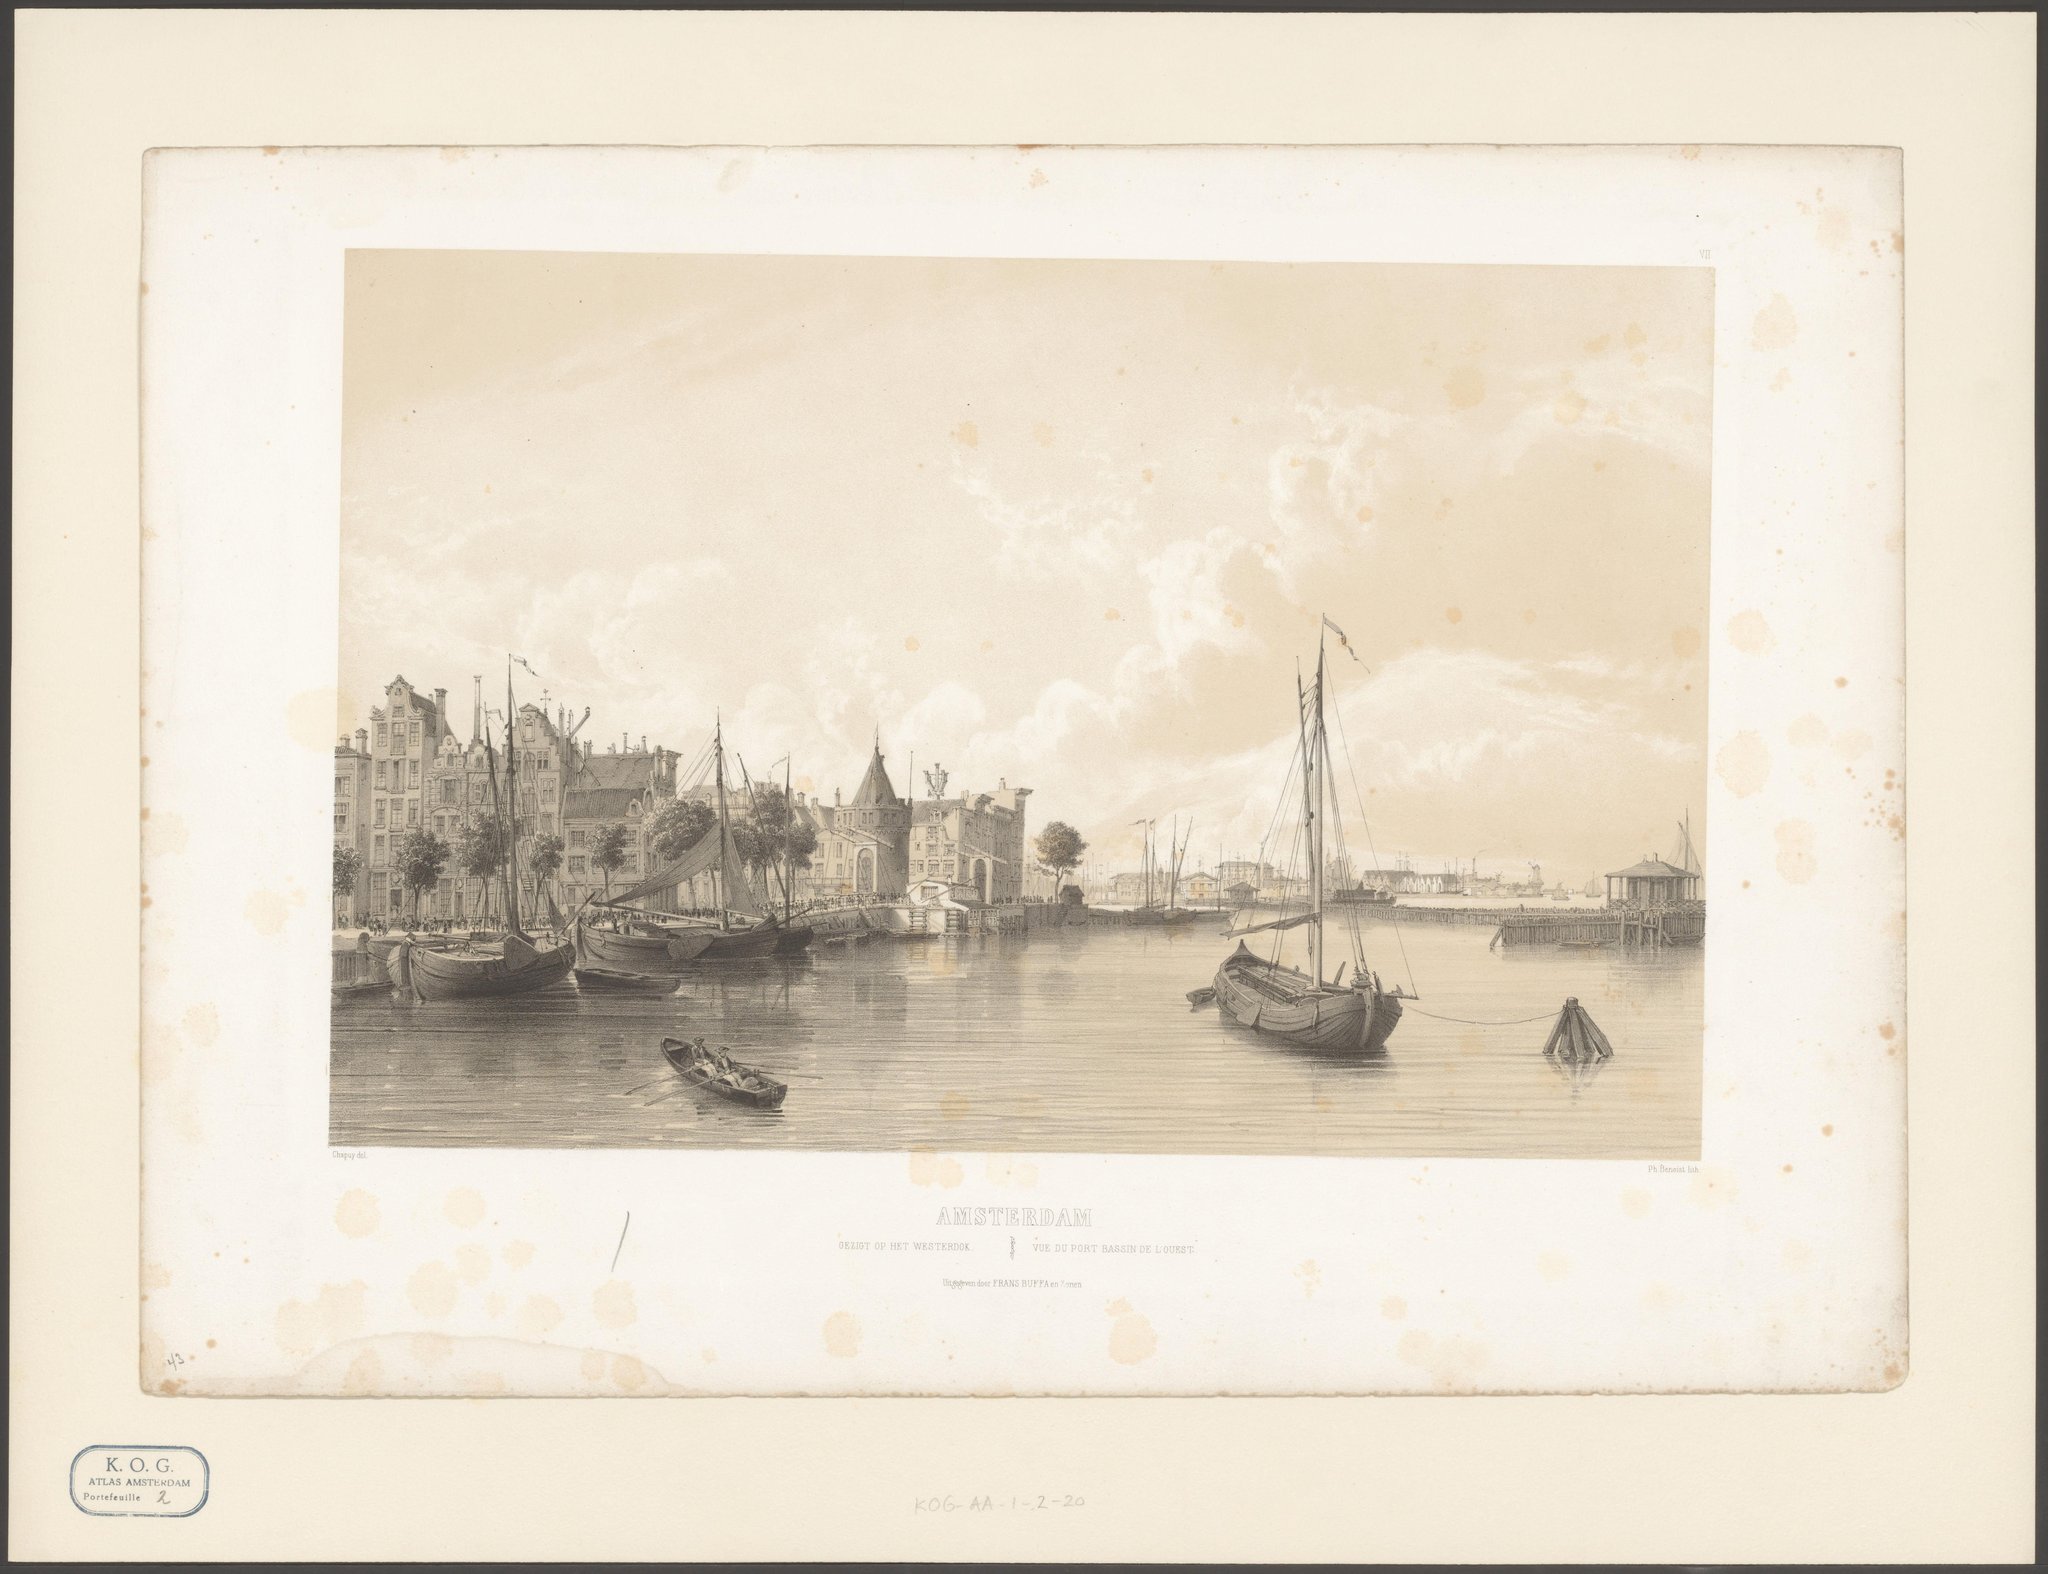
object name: print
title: Amsterdam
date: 1851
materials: paper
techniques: tone lithography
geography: amsterdam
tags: tower, clock tower ~ monumental adornment, city-view in general; 'veduta', river, ships (in general) - cc - more than one ship, bridge in city across river, canal, etc.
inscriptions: collector's mark: ‘2’ Lugt 1641b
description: Onderwerpsrubriek binnen de Atlas Amsterdam: Gezichten van het IJ op het Oostelijk gedeelte der stad, Nieuwebrug tot Zeeburg.